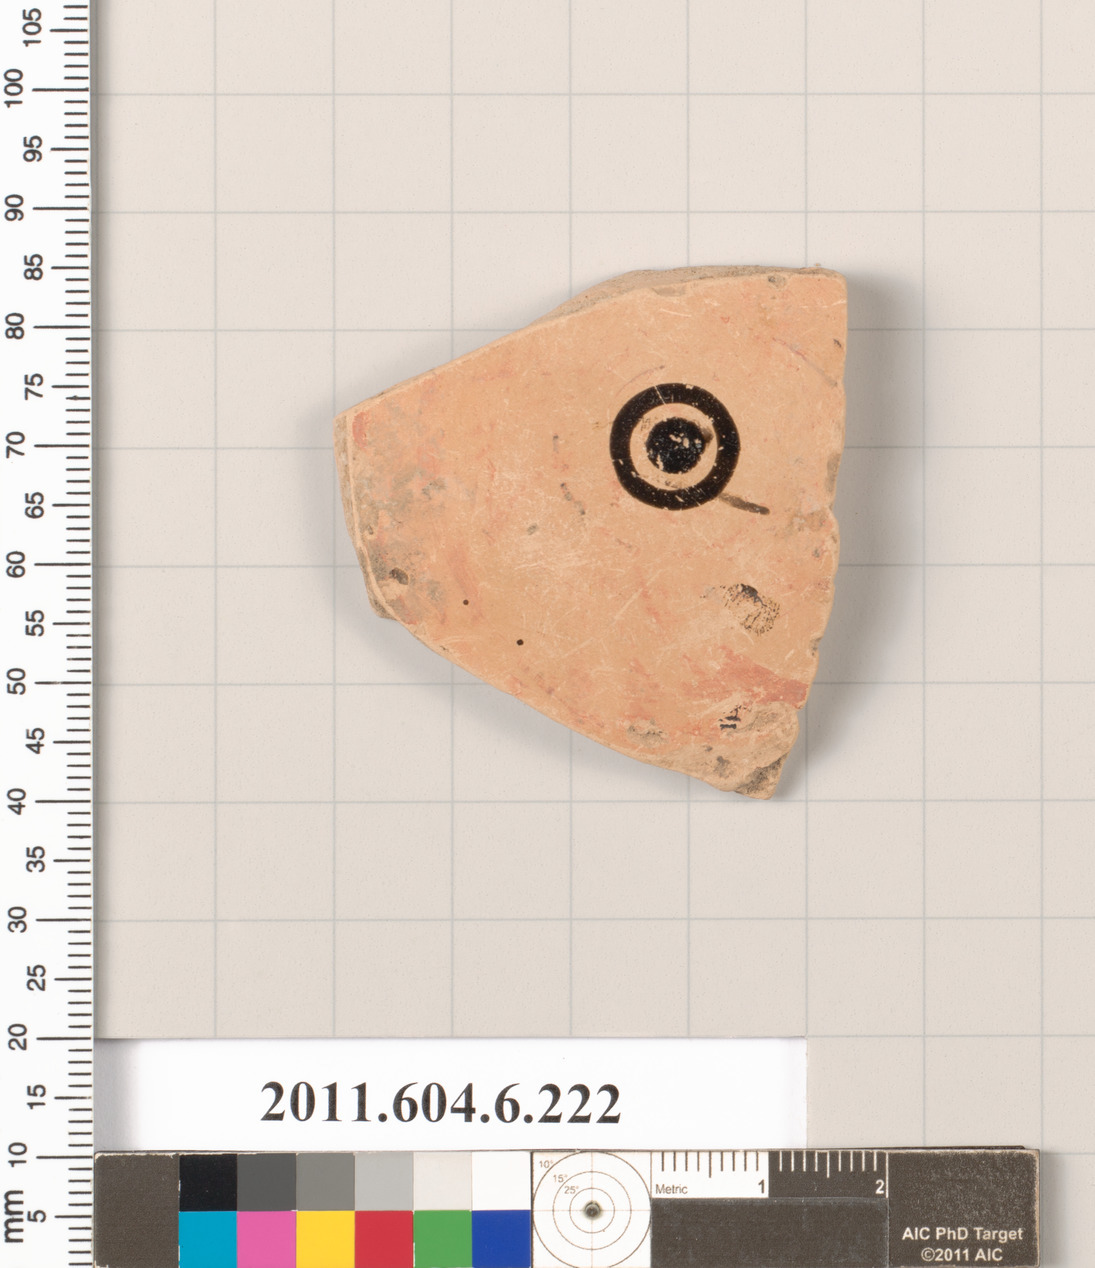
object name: undetermined open shape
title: Terracotta fragment of an open shape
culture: greek, attic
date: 600-401 BCE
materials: terracotta